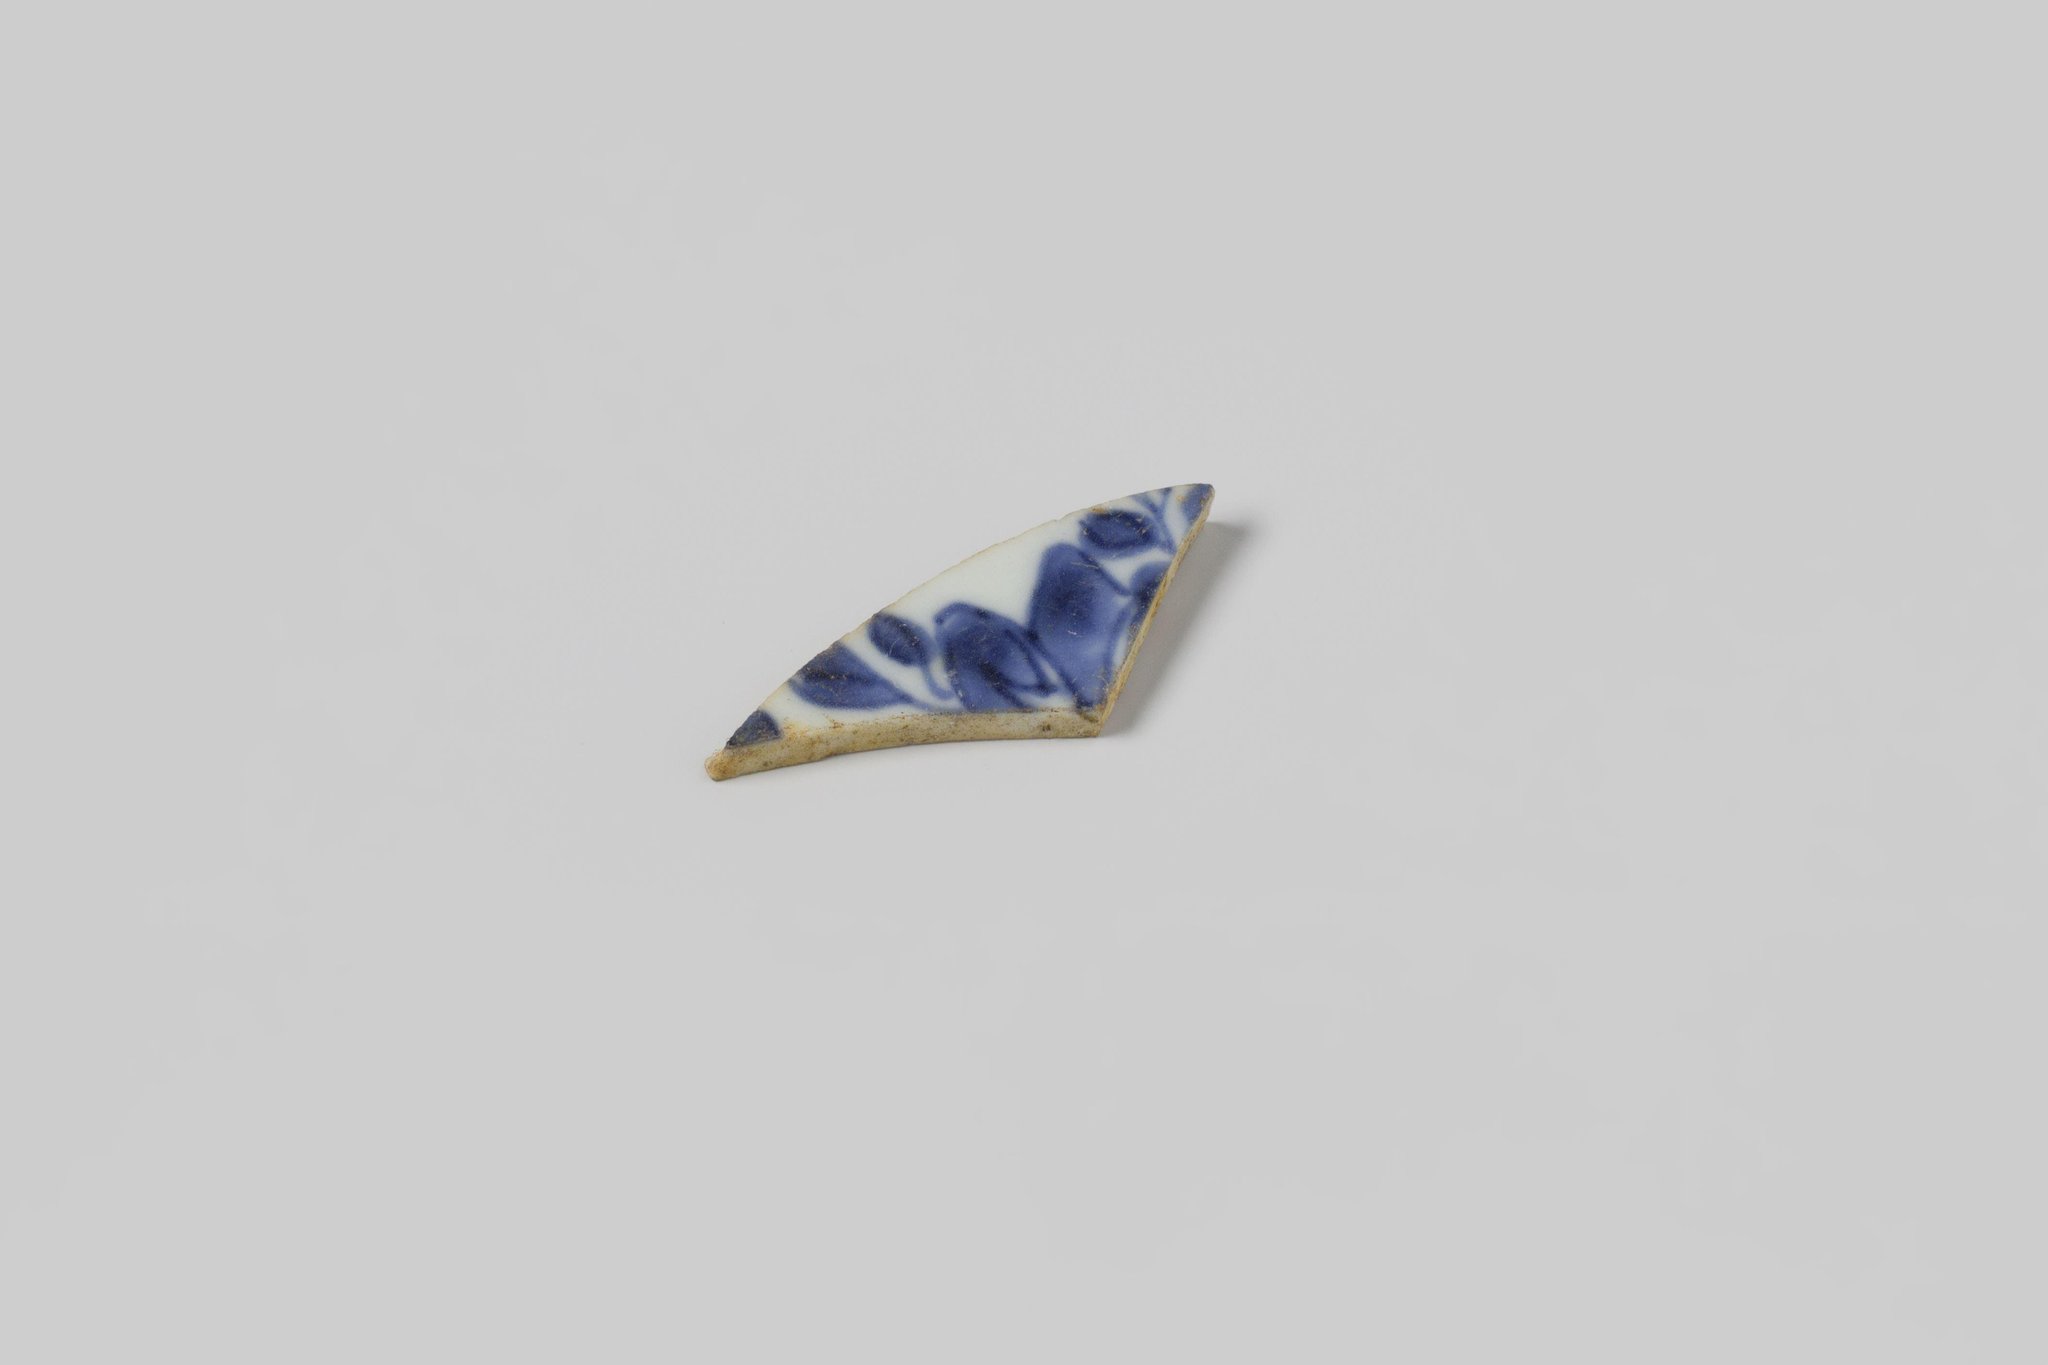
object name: plate dish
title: Scherf van een bord uit het wrak van de Oost-Indiëvaarder Hollandia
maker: Anonymous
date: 1700-1743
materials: porcelain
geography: netherlands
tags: verenigde oostindische compagnie, hollandia (schip), annet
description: Porcelain, plate, type 3; fragm of rim or centre, sim. NG 1980-27H3202c.